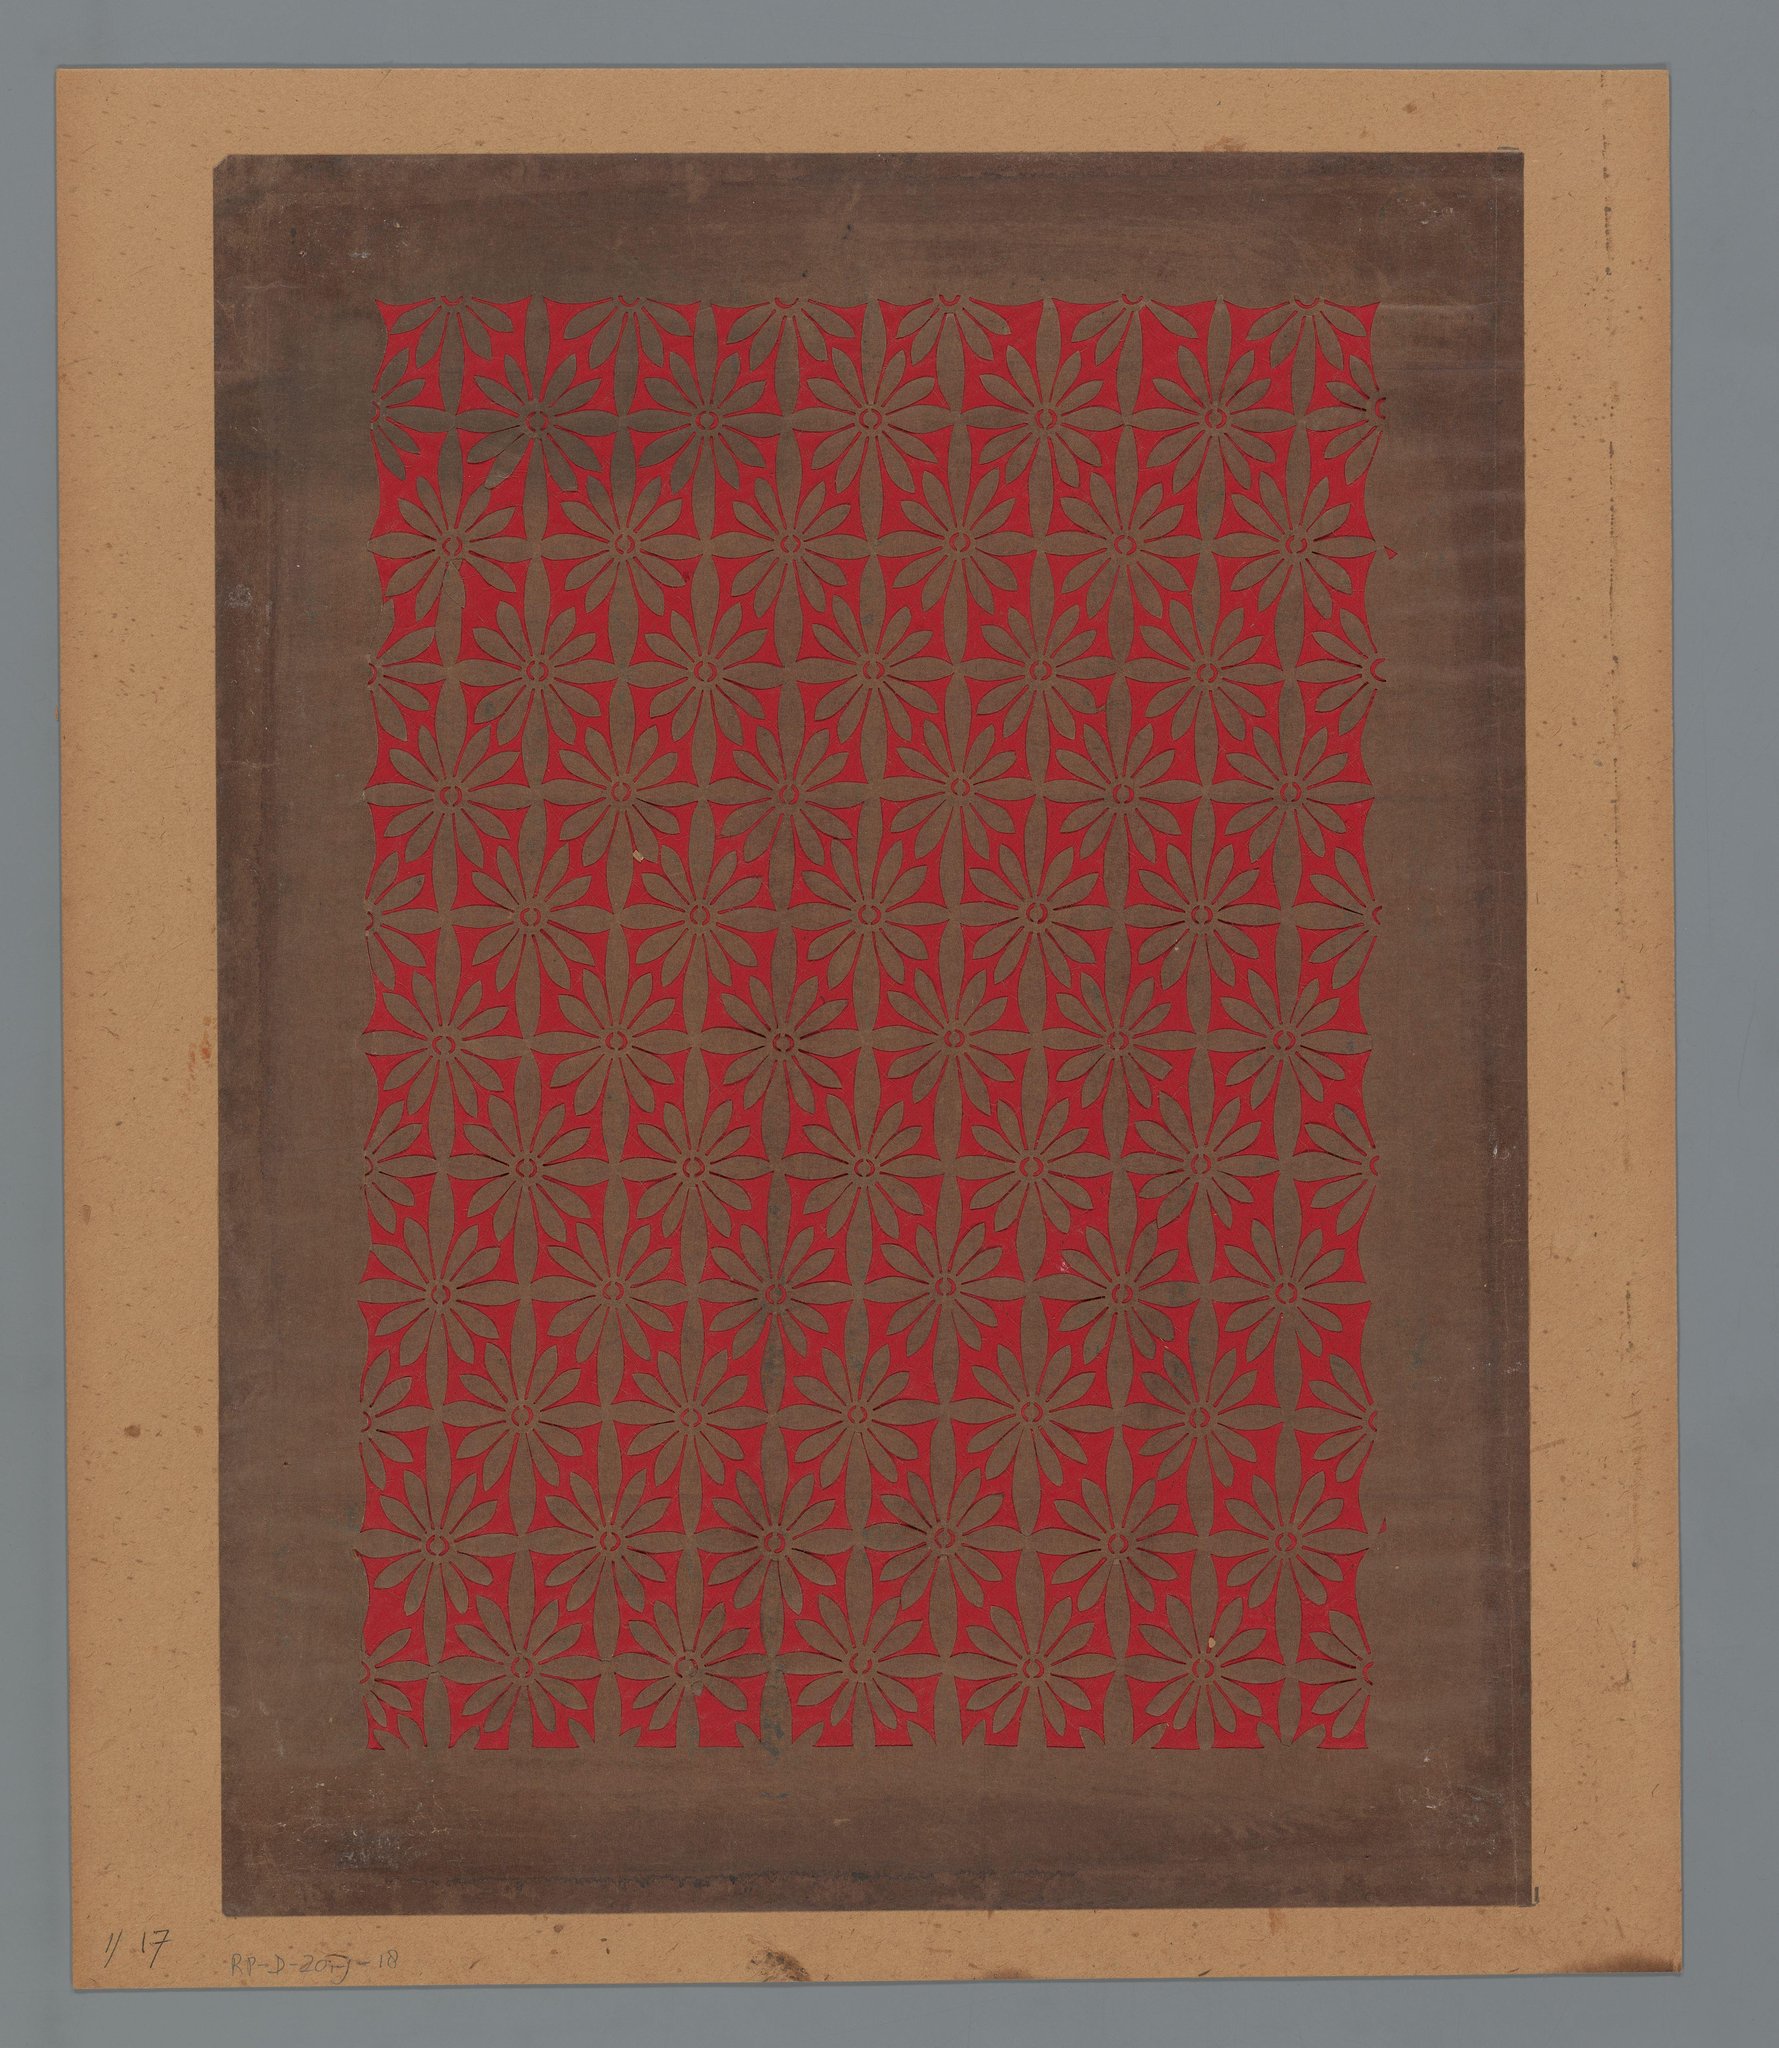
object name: katagami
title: Sjabloon met gestileerde bloem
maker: Anonymous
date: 1800-1909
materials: paper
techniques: cutting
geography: japan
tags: flowers ~ ornament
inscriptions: stamp: ‘Museum van Kunstnijverheid Haarlem’, number: ‘1/17’, stamp: ‘Afgeschreven W...’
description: Japanse sjabloon (katagami) met een uniform patroon van een gestileerde bloemvorm.